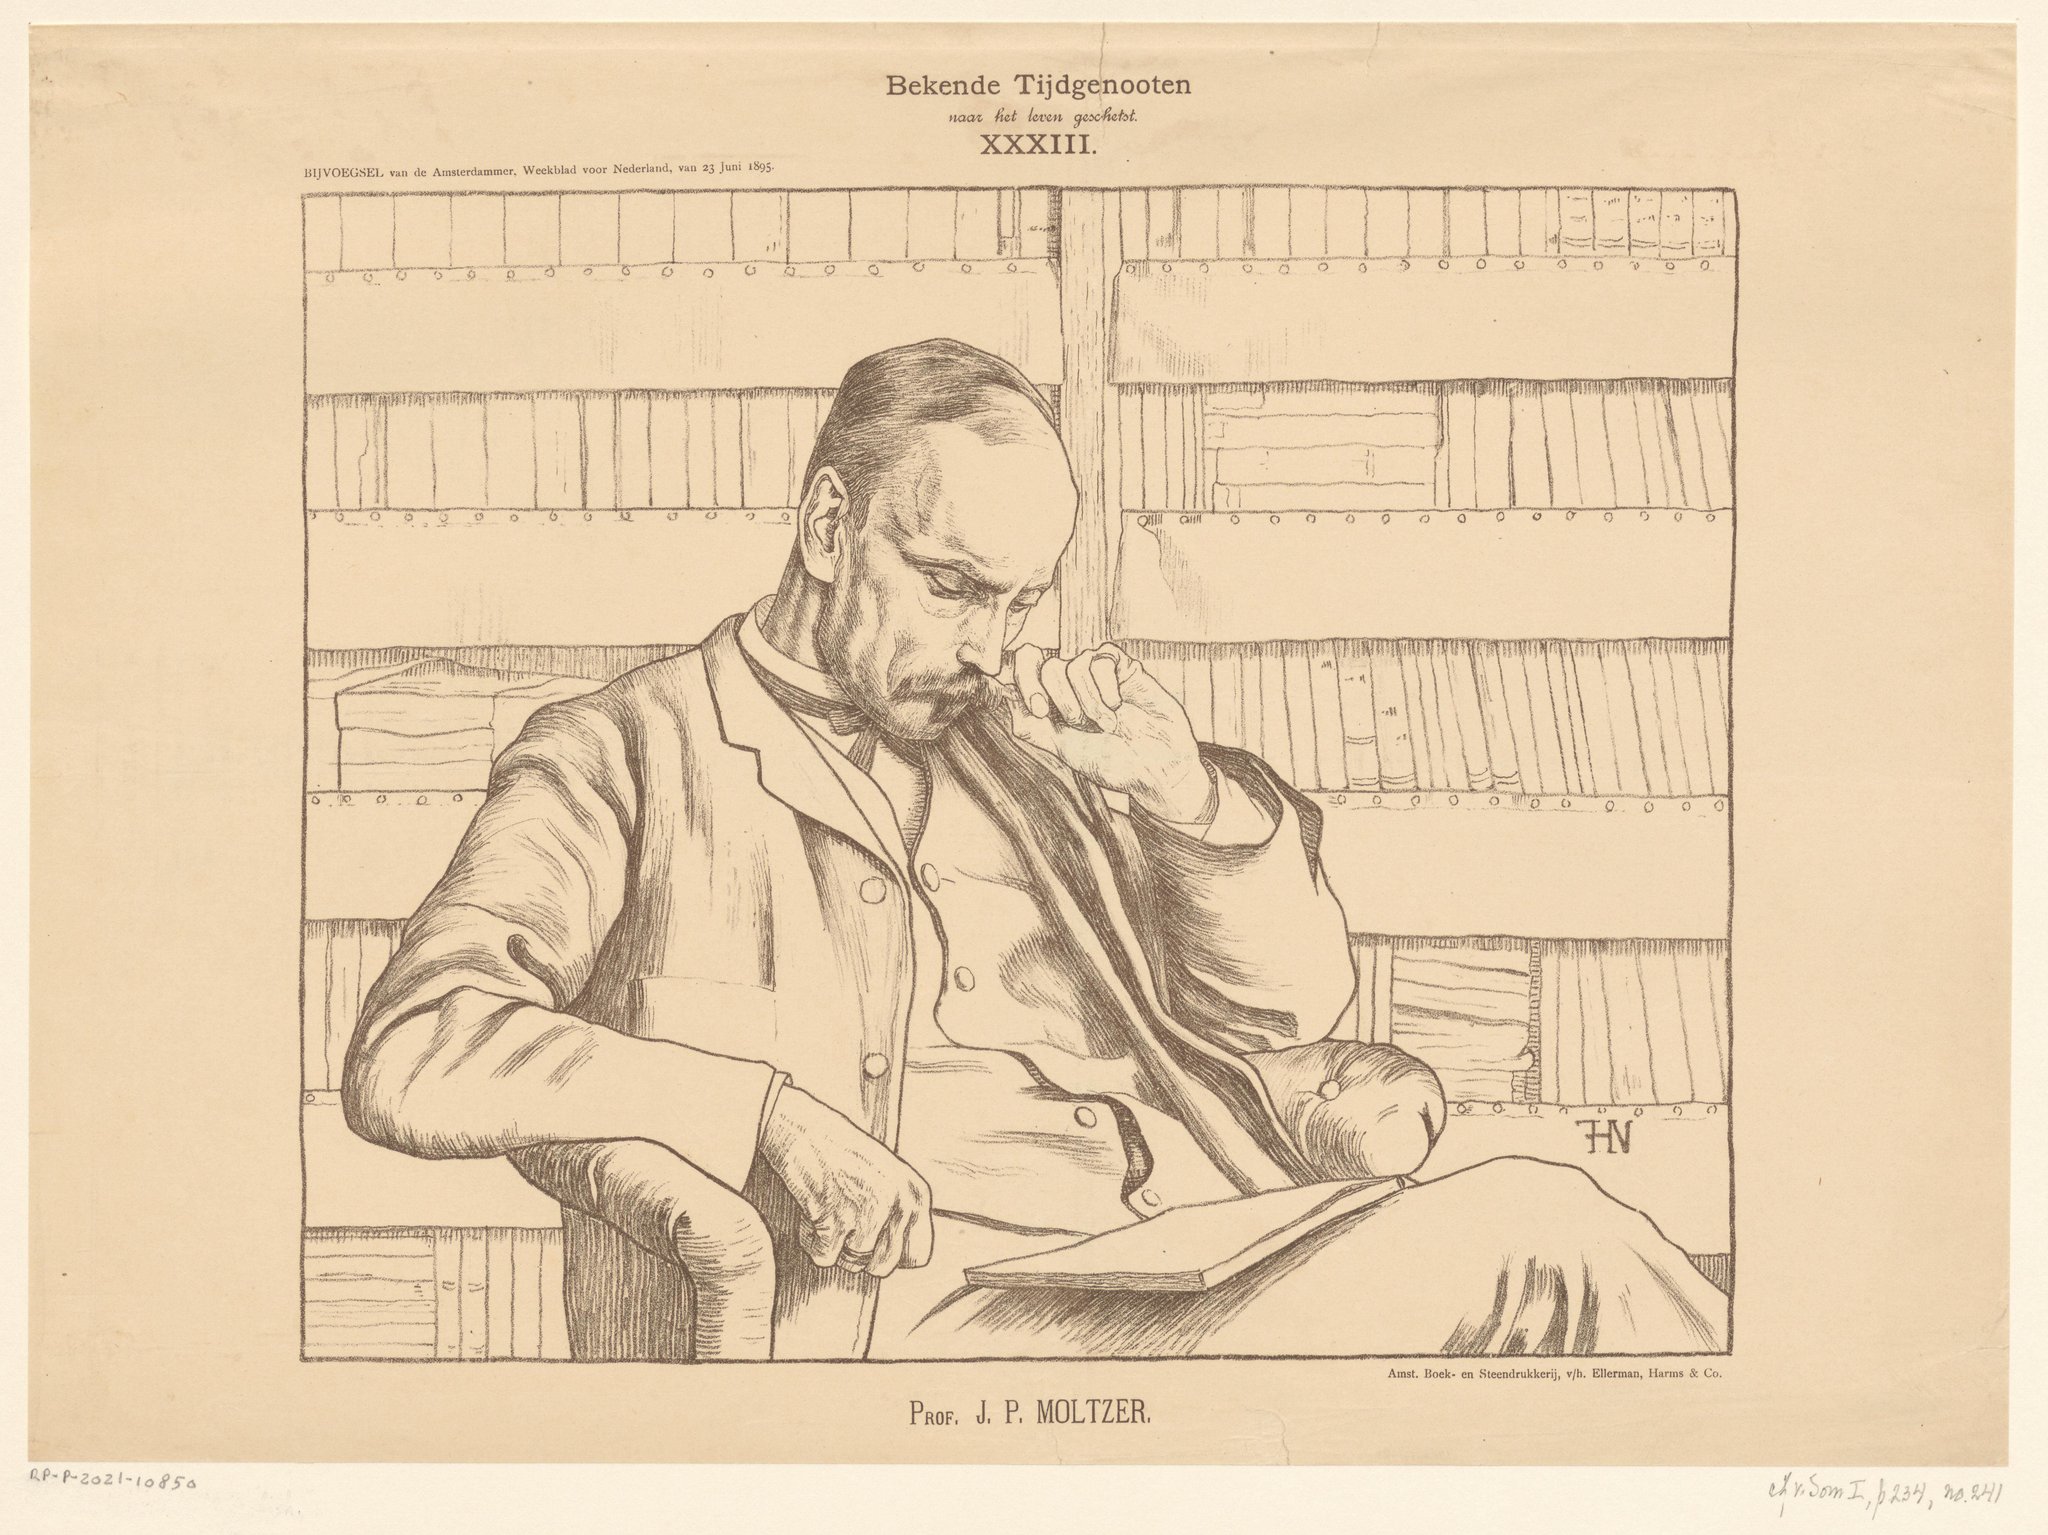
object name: print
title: Bekende tijdgenooten, naar het leven geschetst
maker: ferdinand hart nibbrig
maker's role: draughtsman, painter, print maker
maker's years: 1866-1915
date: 1895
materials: paper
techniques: lithograph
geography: amsterdam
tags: amsterdam, jacob pieter moltzer, reading, historical persons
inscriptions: collector's mark: Lugt 2228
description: Prent is verschenen als bijvoegsel van: De Amsterdammer. Weekblad voor Nederland (1895), nr. 939, 23 juni 1895.